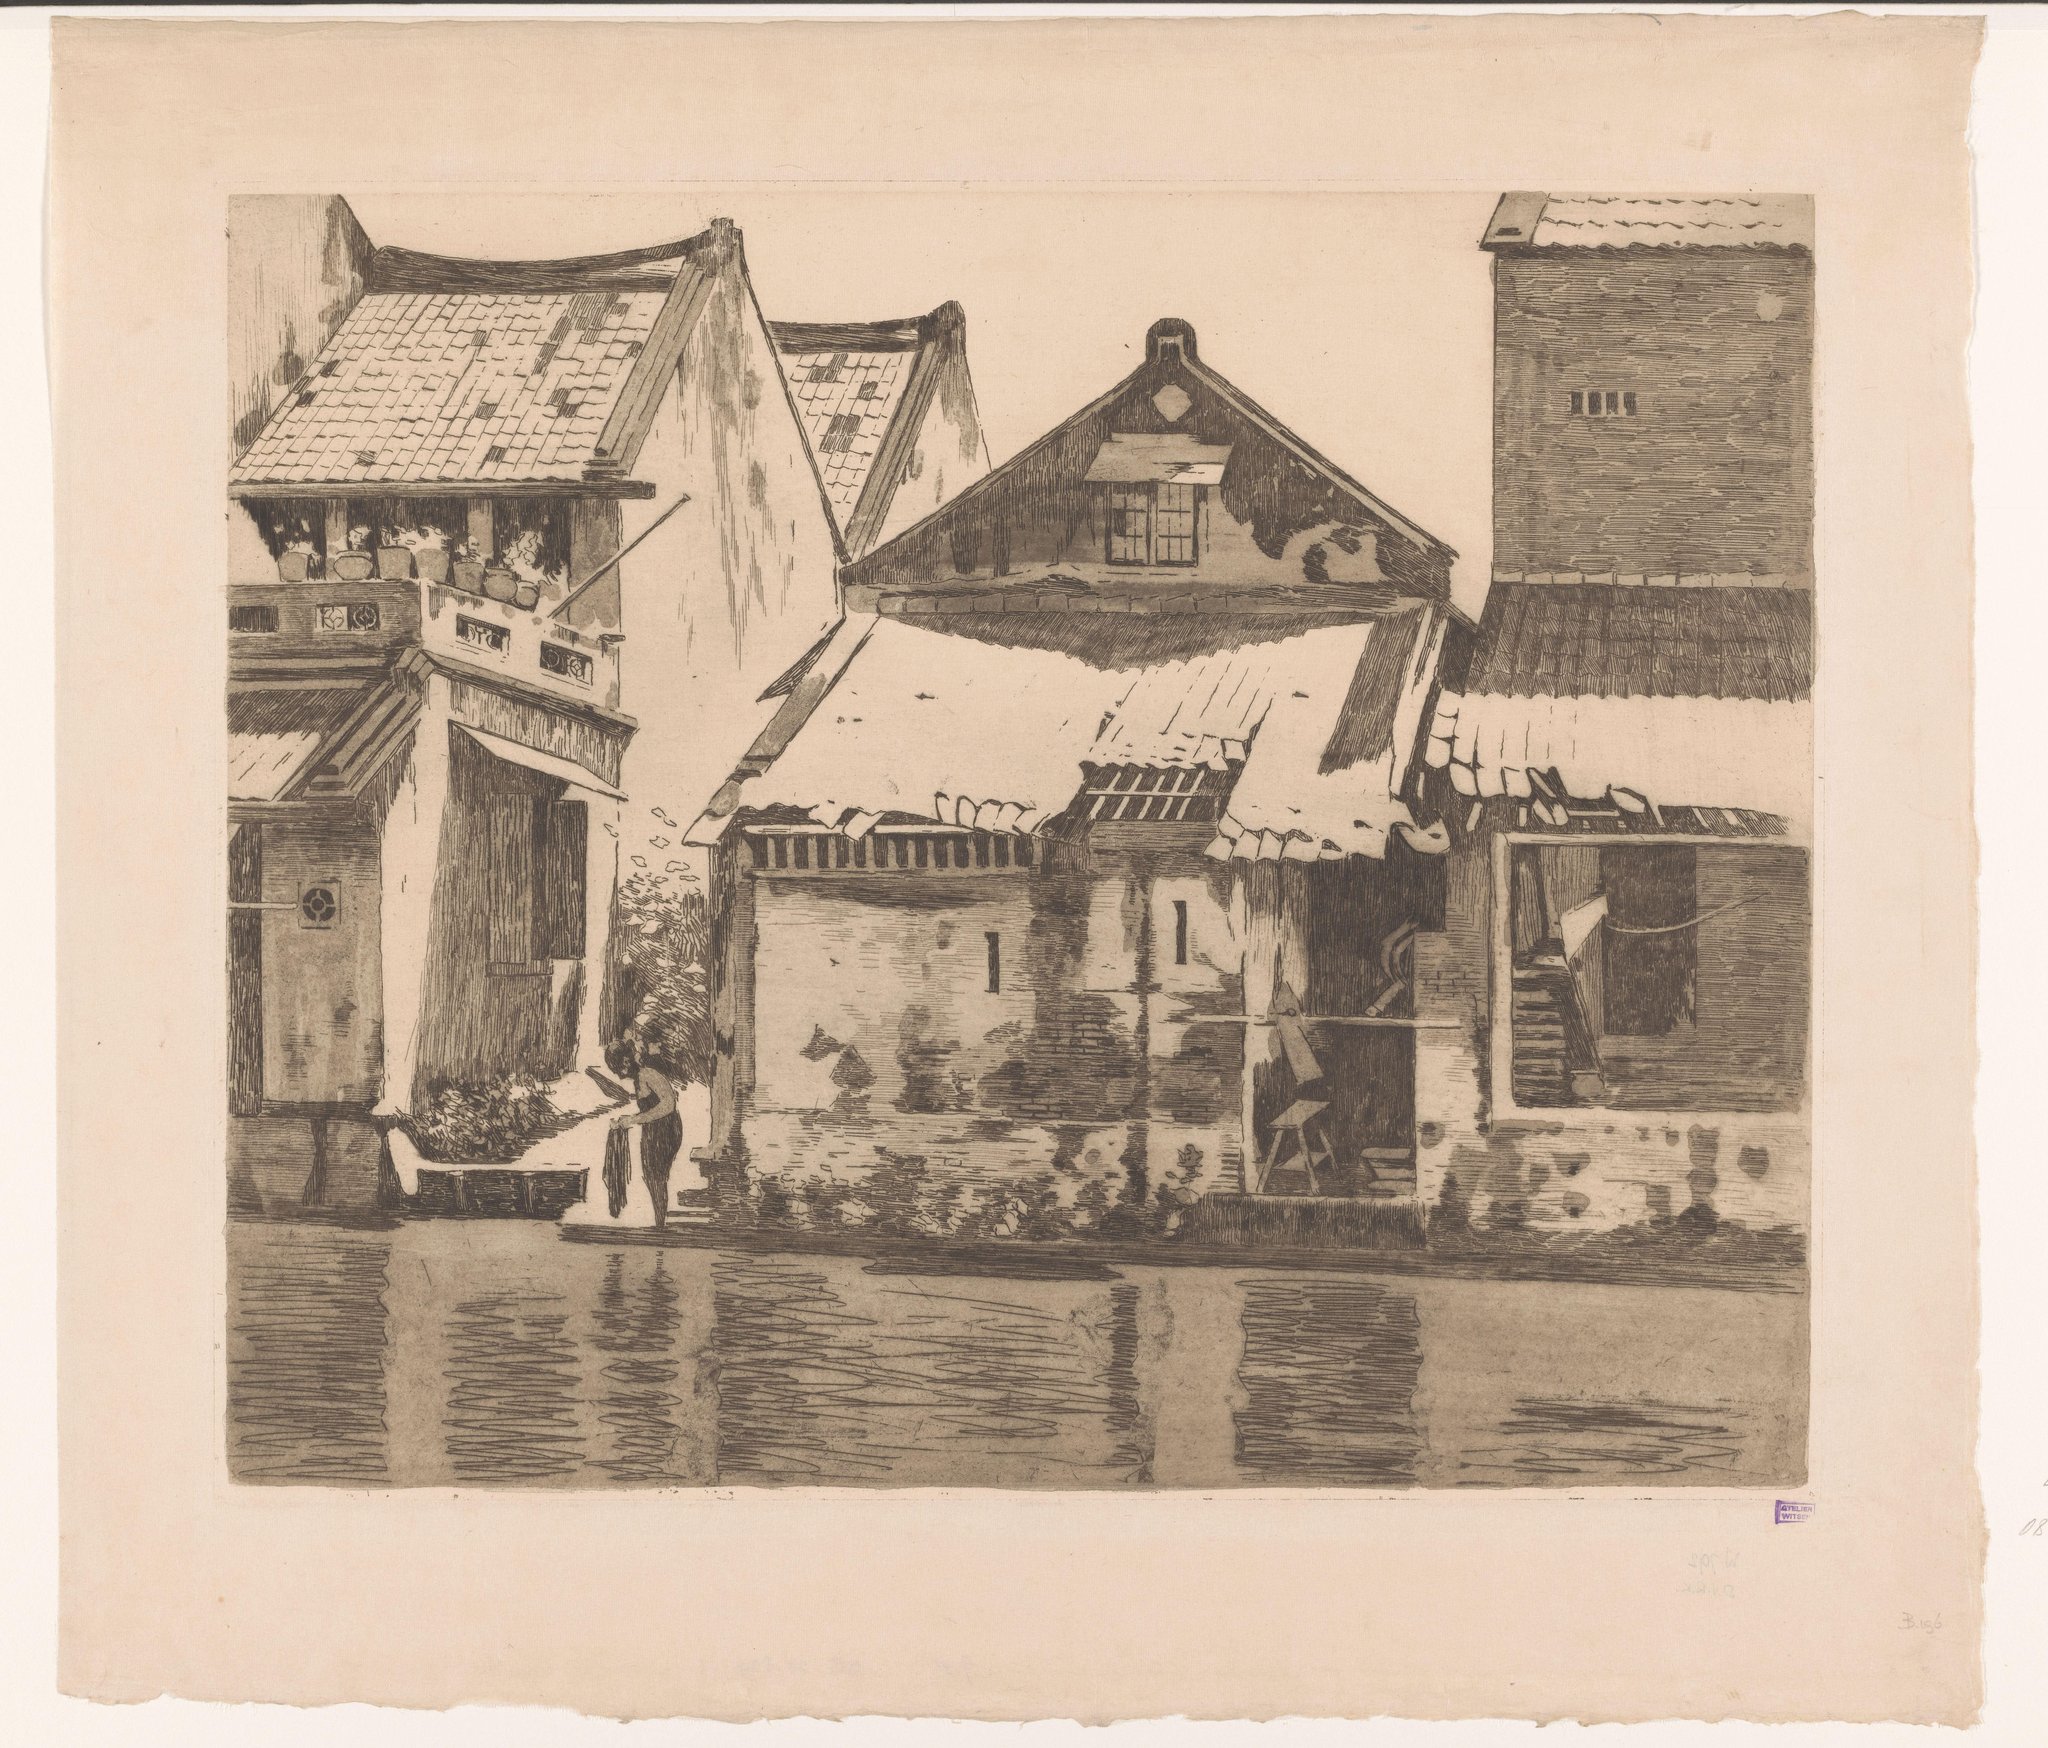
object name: print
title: Woningen langs een rivier in Batavia met een vrouw die kleding wast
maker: willem witsen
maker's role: draughtsman, painter, print maker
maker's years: 1860-1923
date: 1921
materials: paper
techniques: aquatint, etching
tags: urban housing, laundering, canals, waters (in city), batavia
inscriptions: workshop stamp: ‘Atelier Witsen’